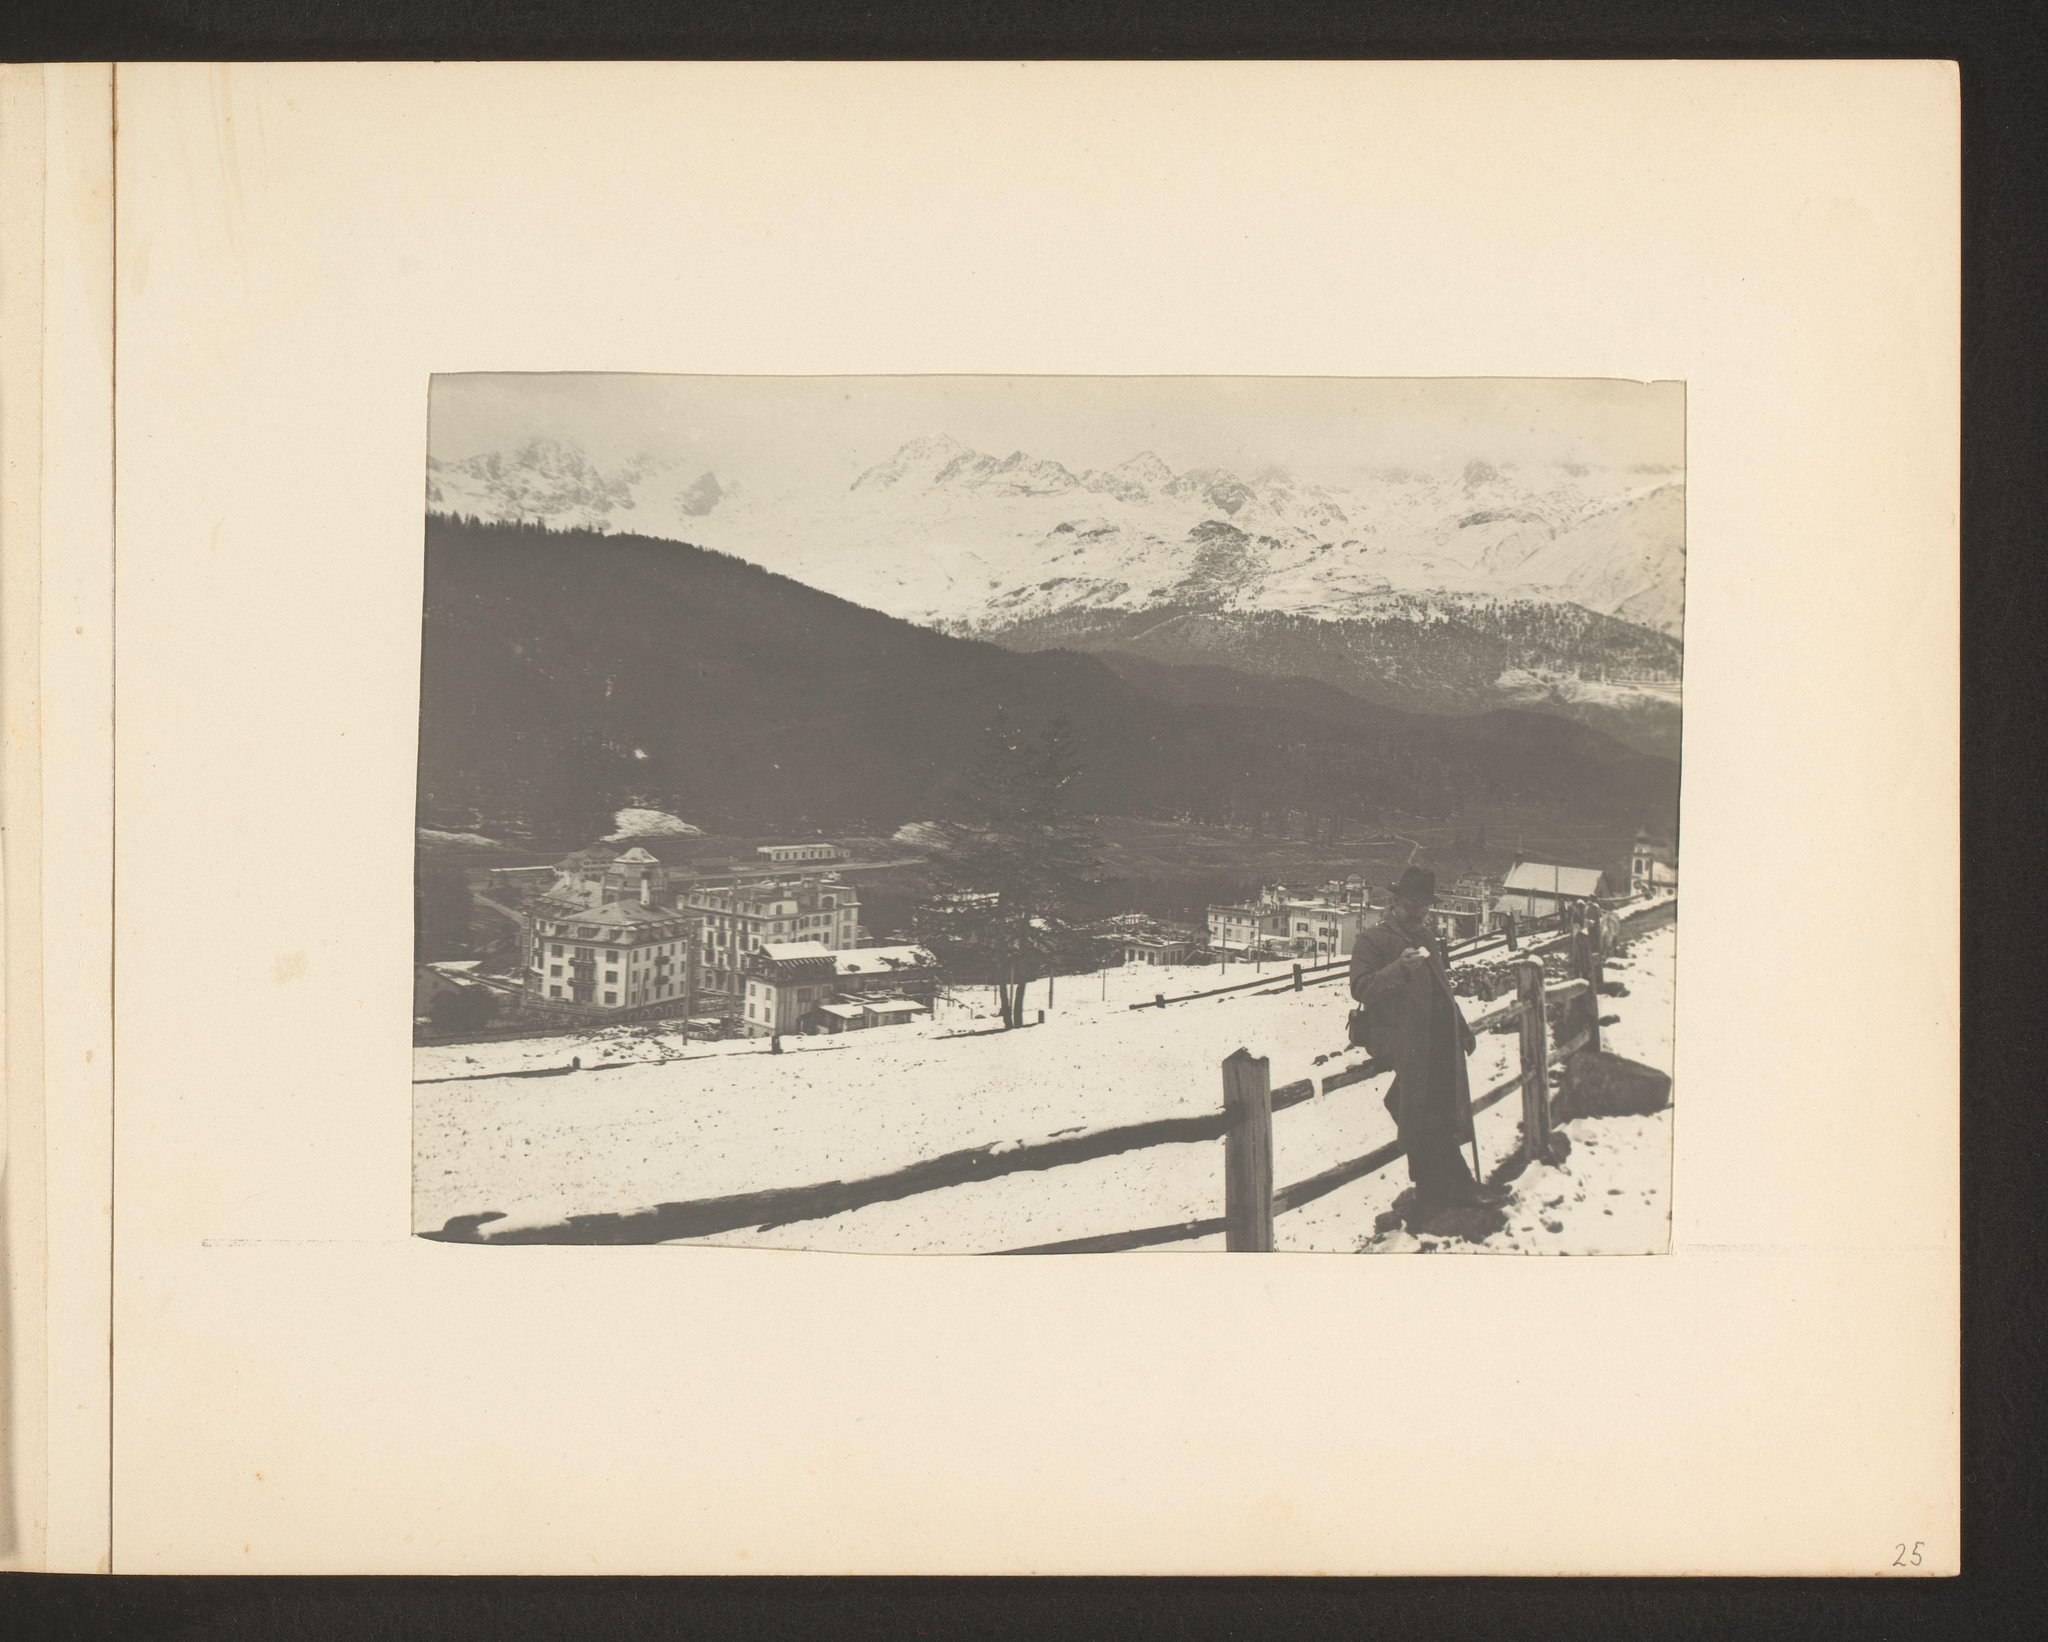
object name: album leaf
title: Gezicht op een dorp in een vallei, rechts een man met hoed leunend tegen een hek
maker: Anonymous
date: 1900-1930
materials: photographic support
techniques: gelatin silver print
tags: dale, valley, city-view in general; 'veduta'